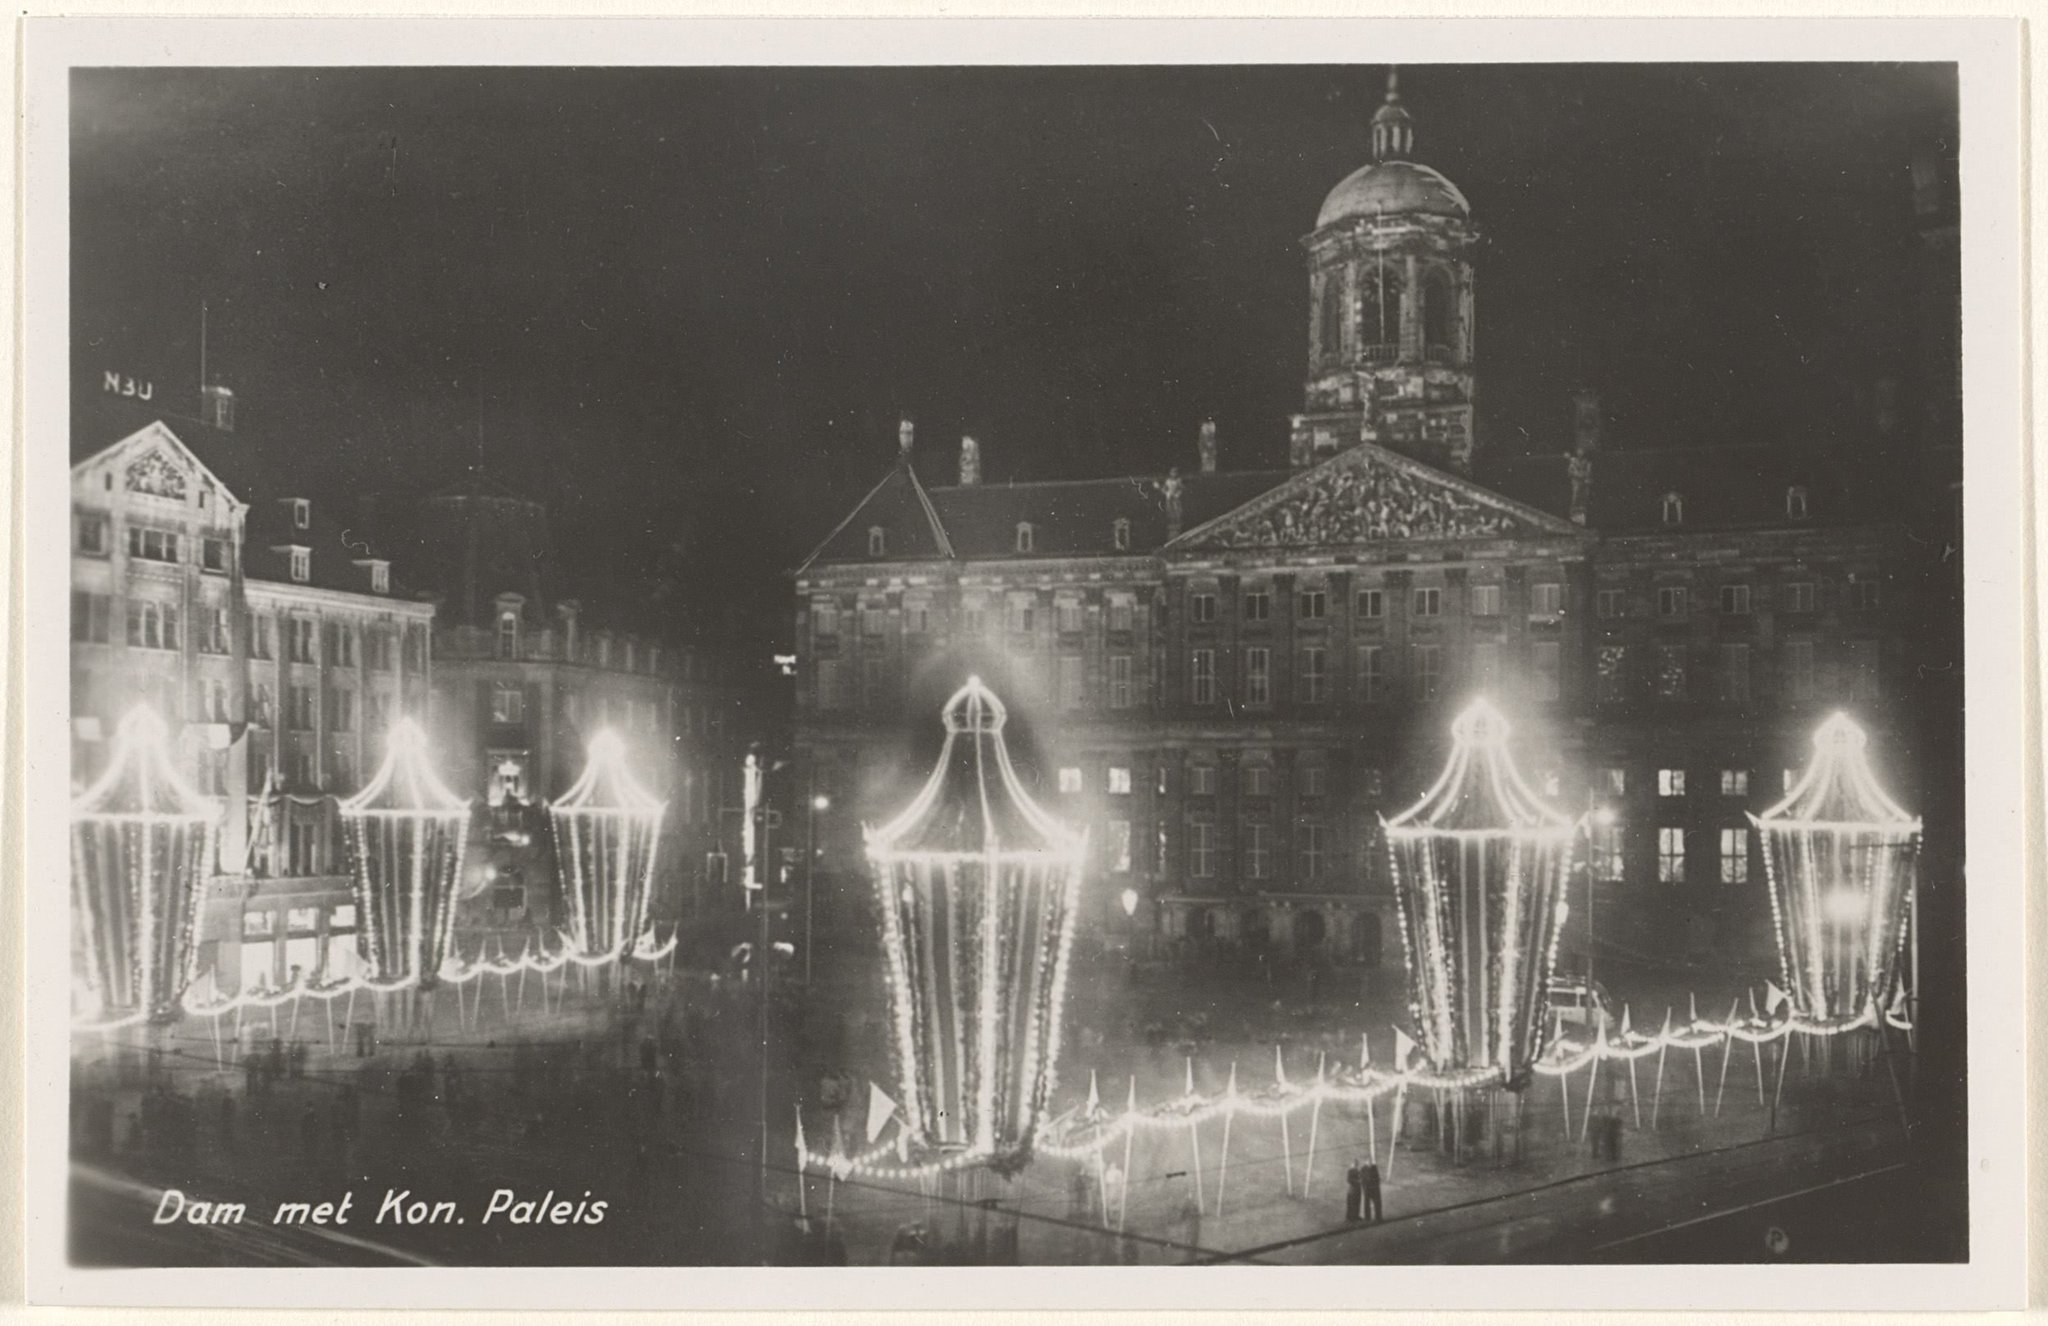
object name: ansichtkaart, prentbriefkaart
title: Koninklijk Paleis op de Dam te Amsterdam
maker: Anonymous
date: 1948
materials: photographic support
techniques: photography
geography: netherlands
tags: royal palace of amsterdam